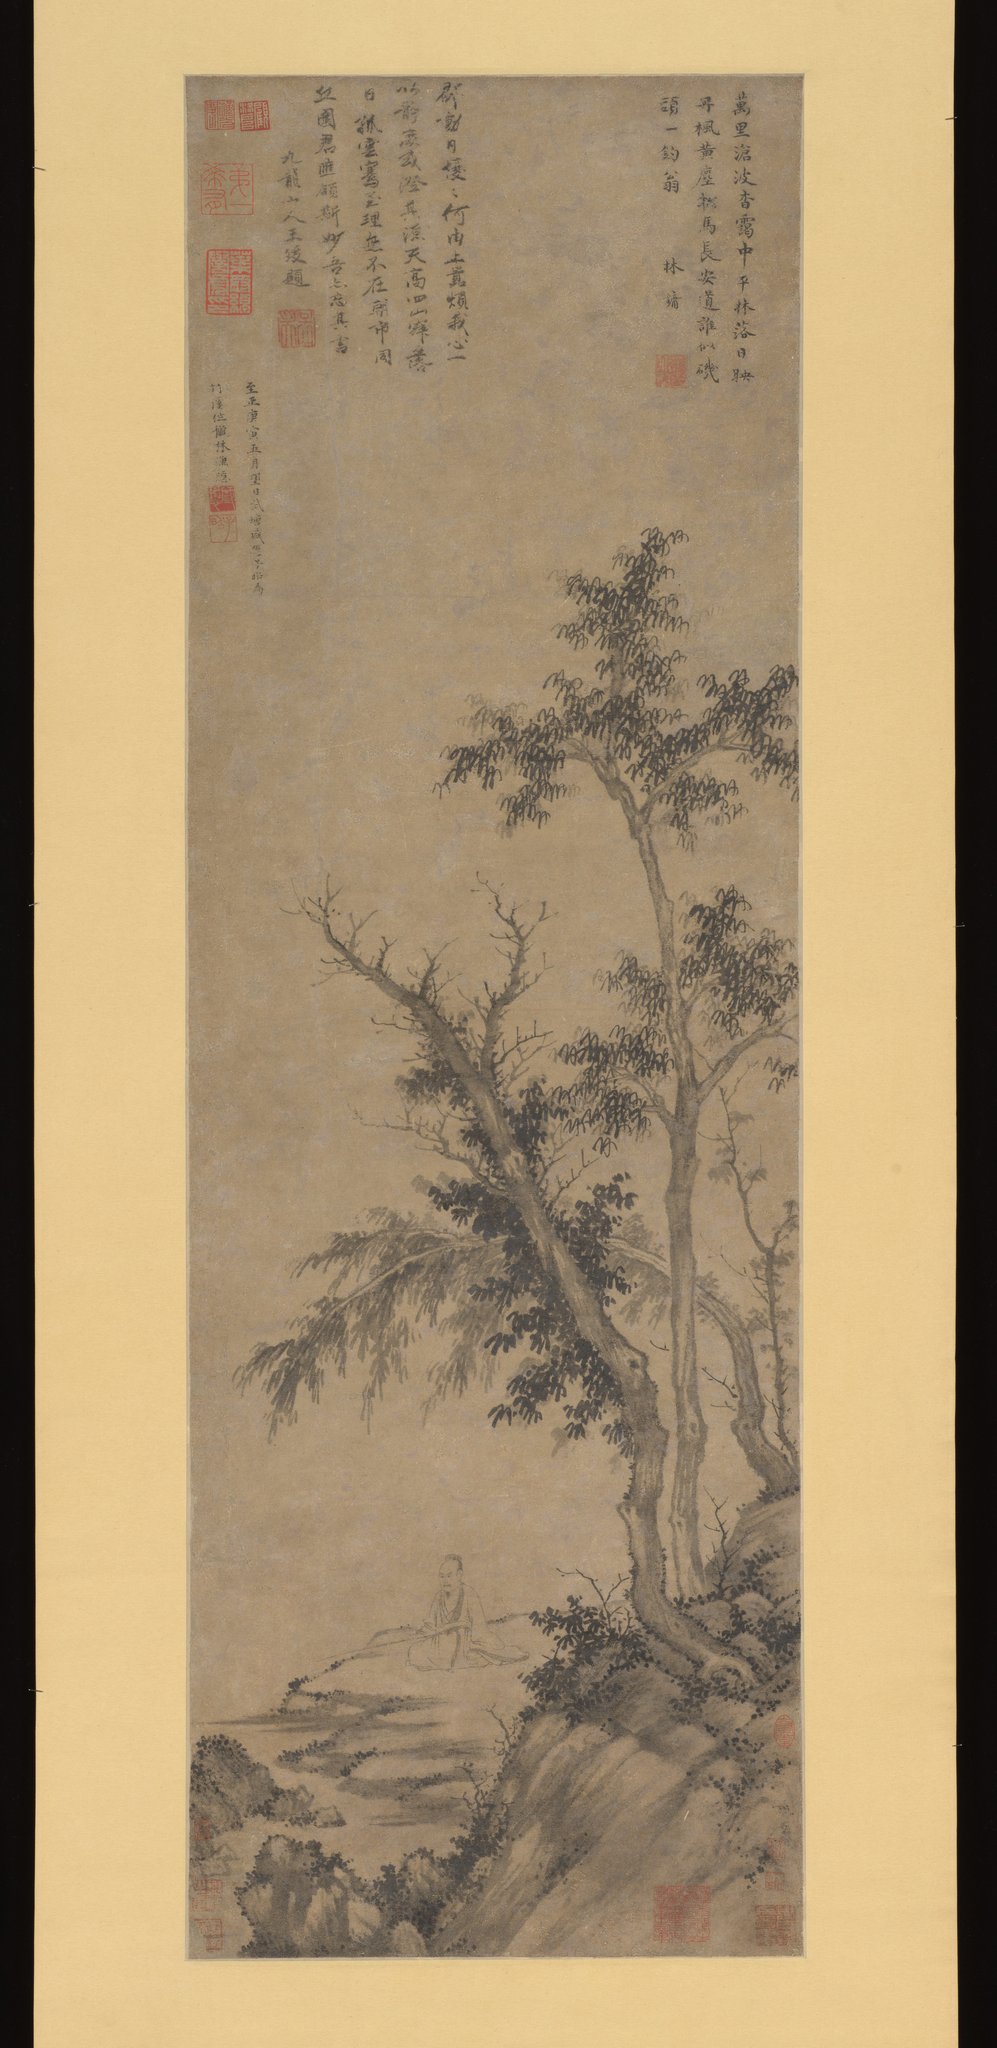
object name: hanging scroll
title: Recluse Fishing by Autumn Trees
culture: chinese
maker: sheng mao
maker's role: artist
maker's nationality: chinese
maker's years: 1310-1360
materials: ink, paper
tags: men,fishing,trees